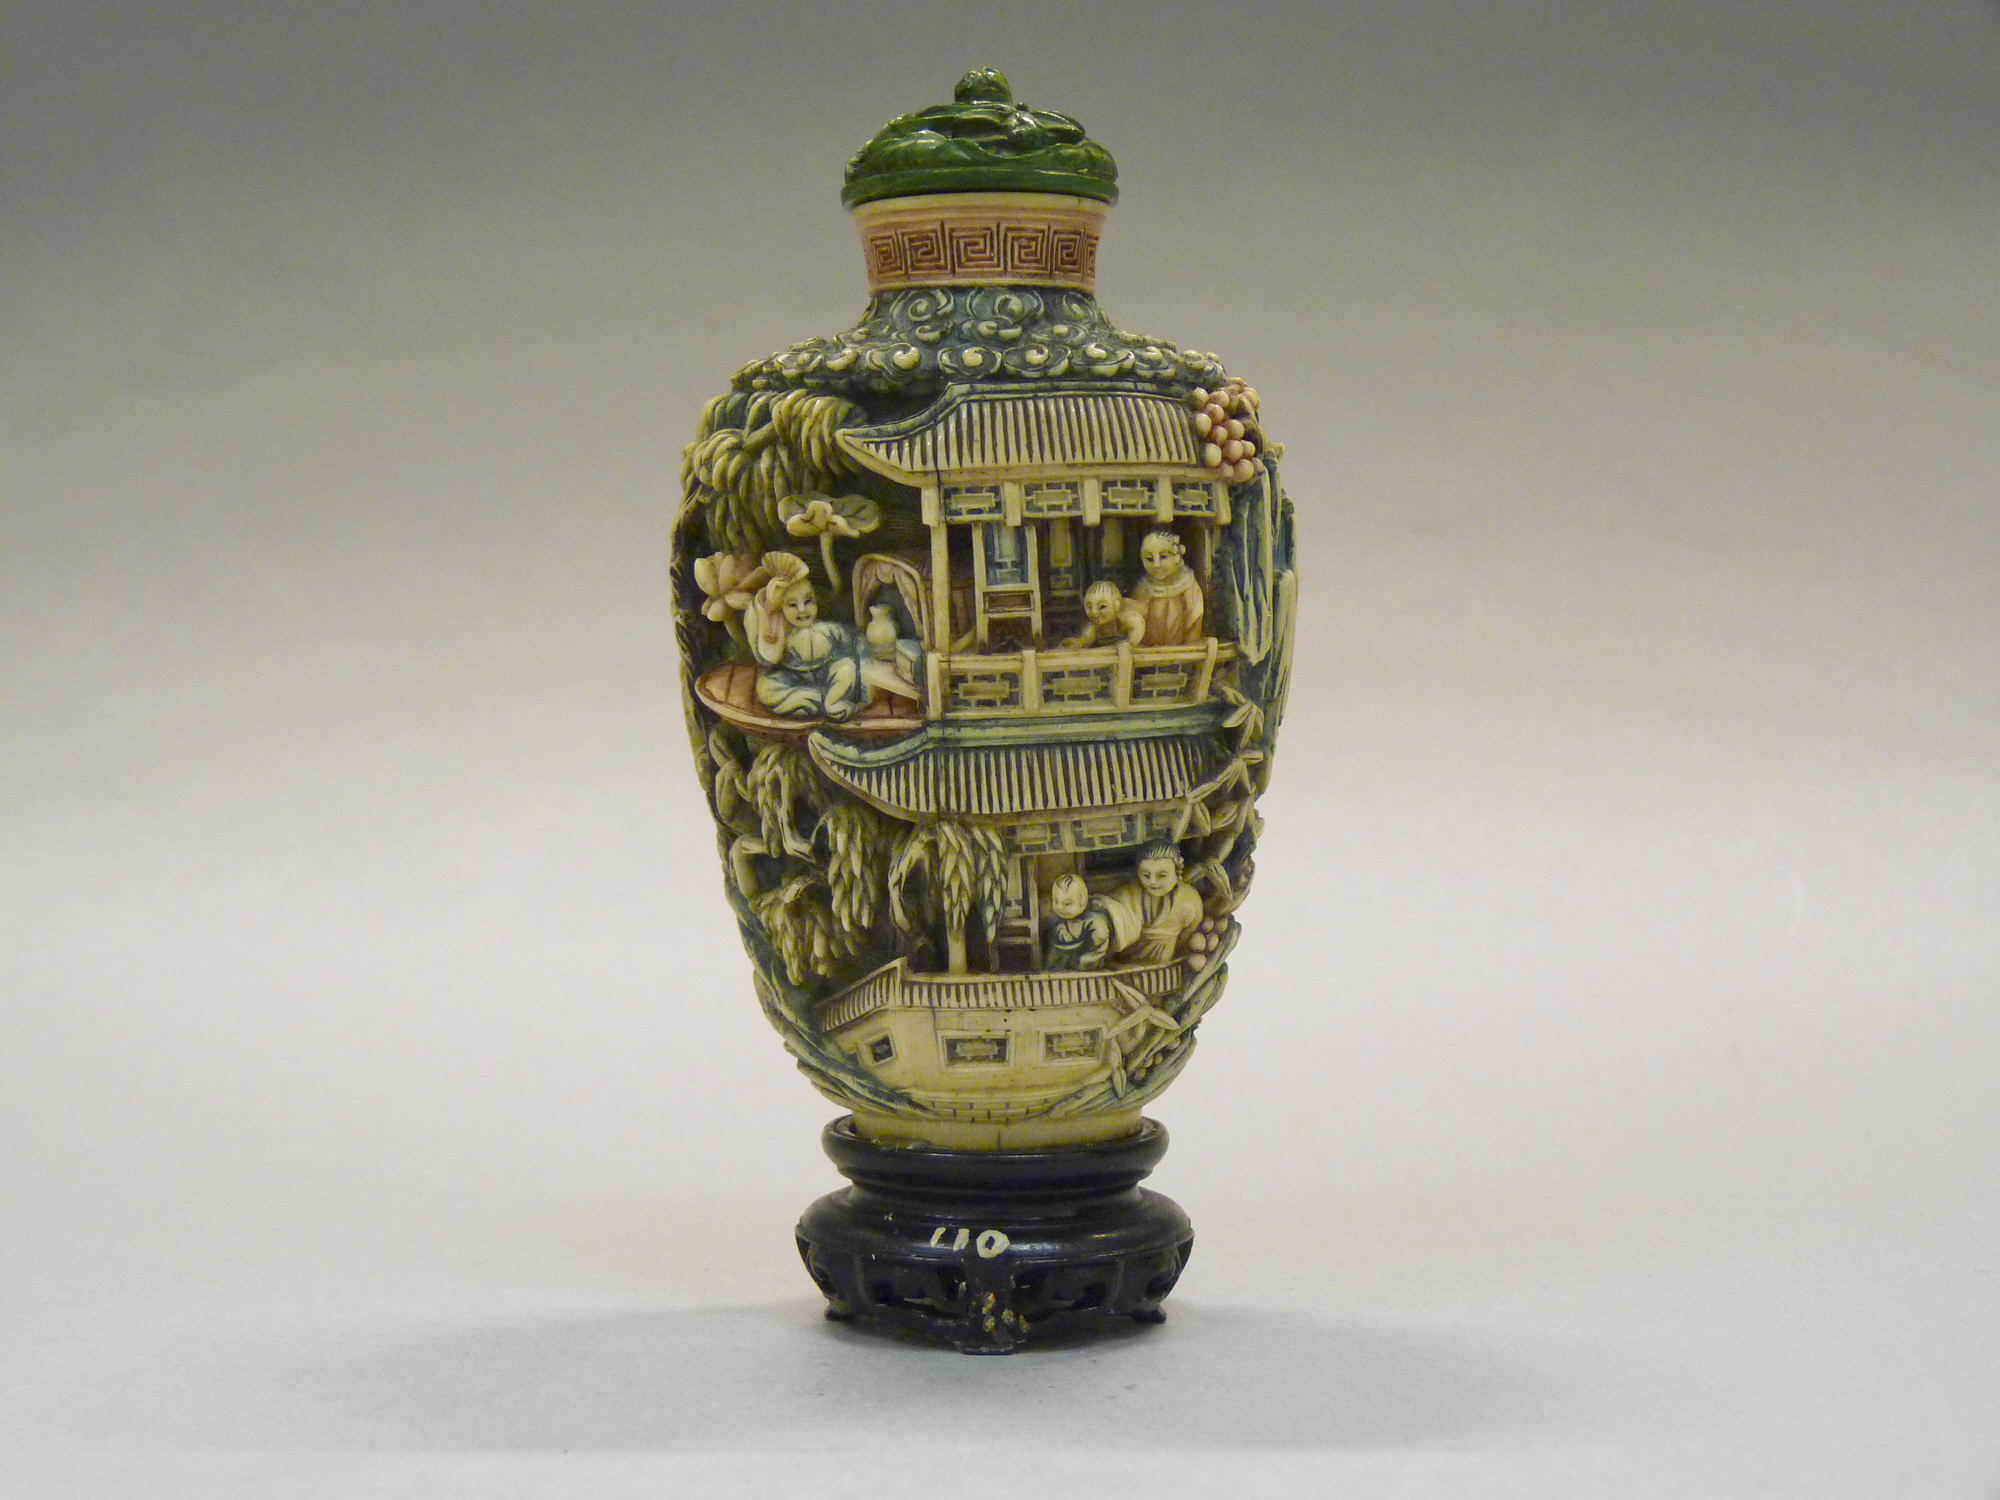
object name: snuff bottle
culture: chinese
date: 1736-1795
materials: ivory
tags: human figures,houses,children,trees